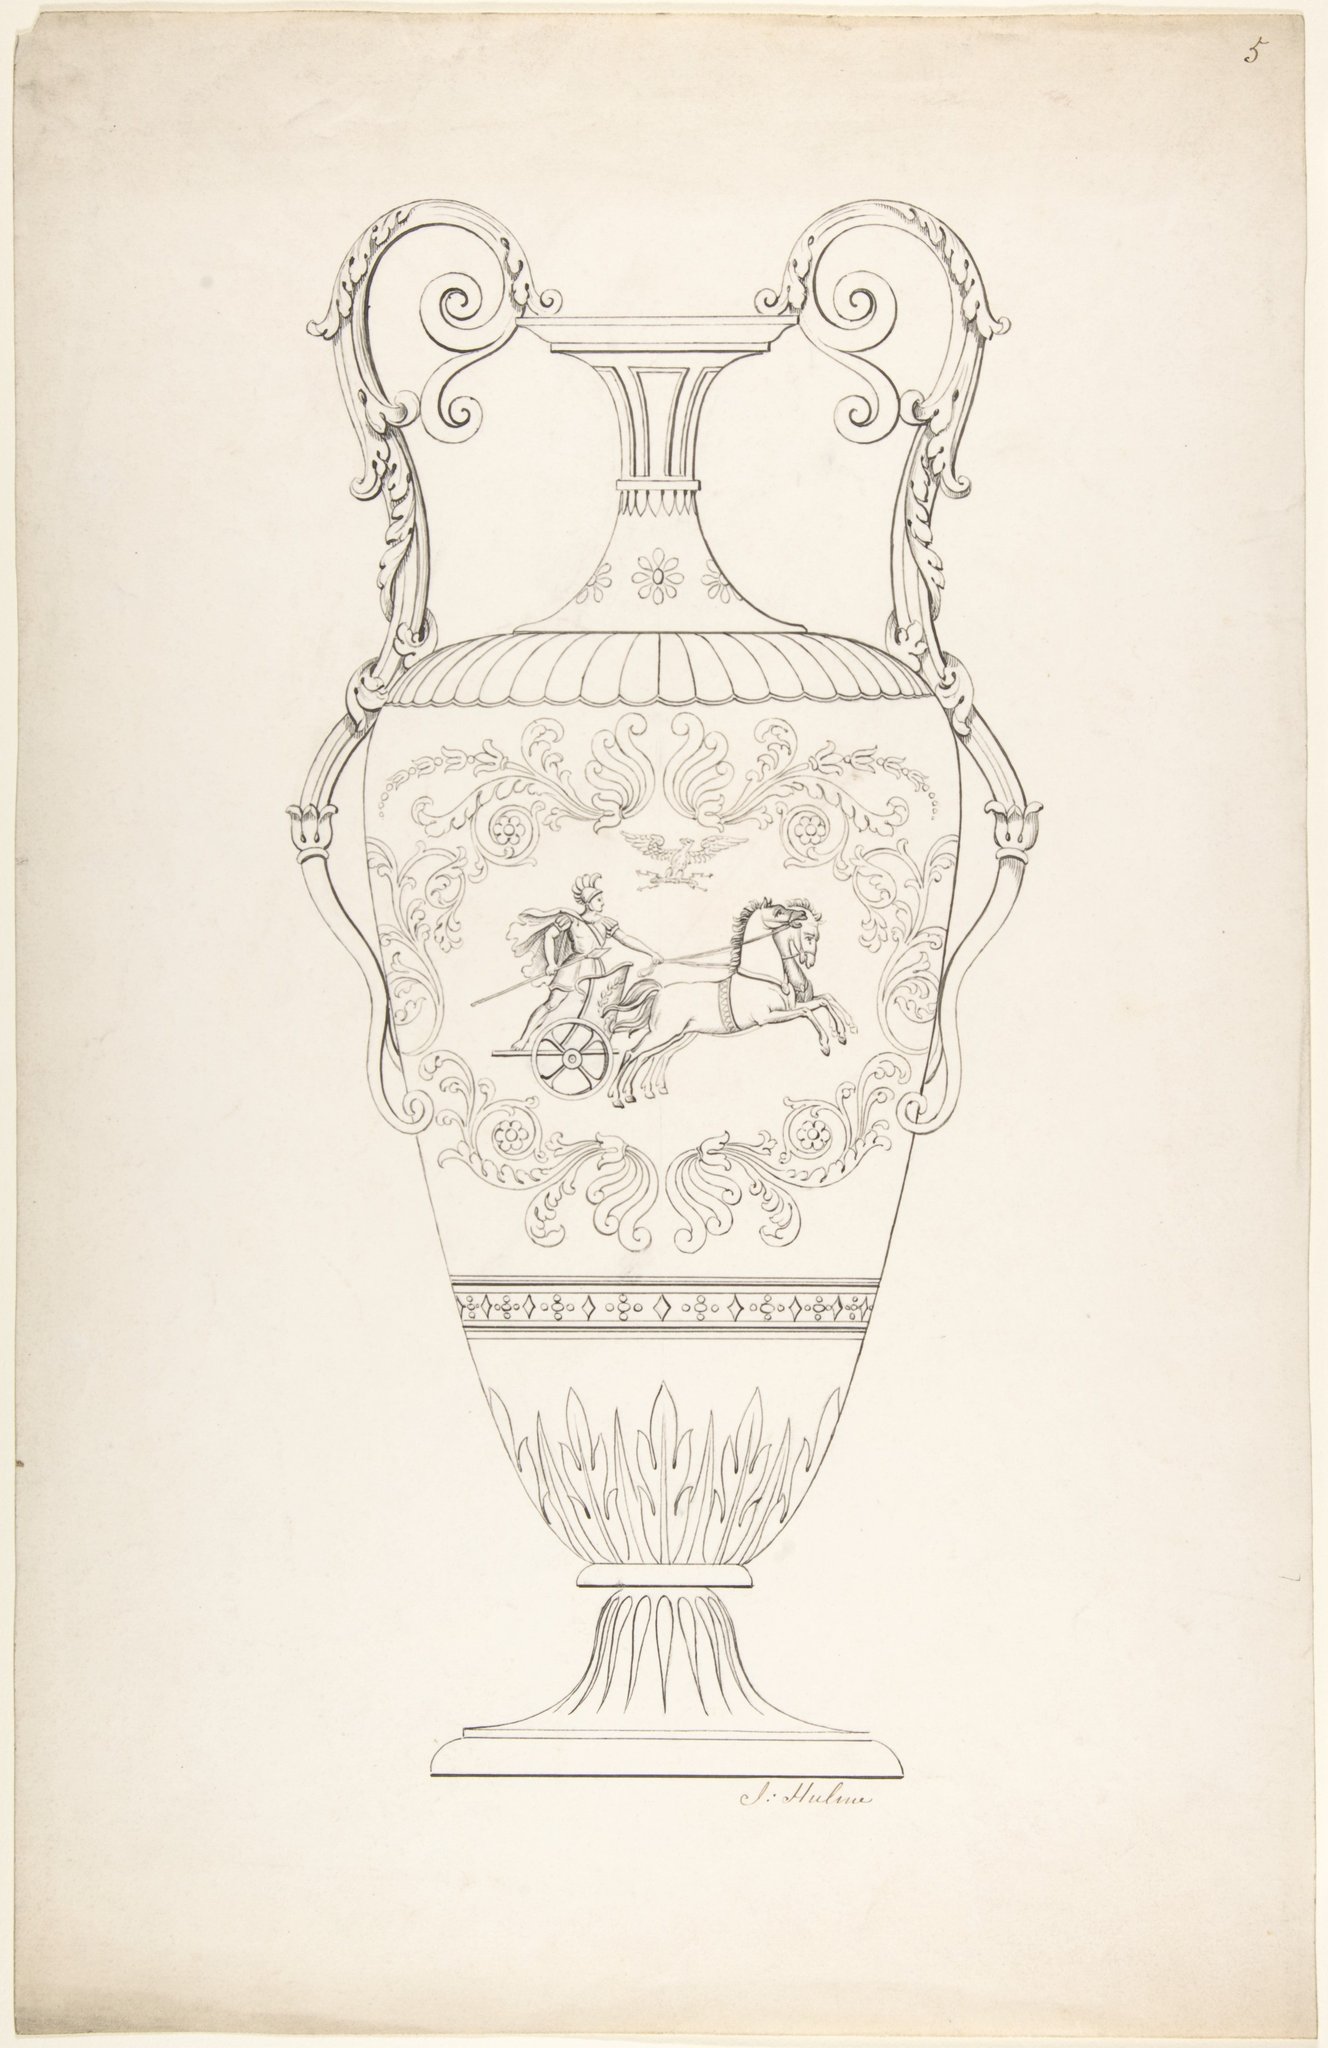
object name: drawing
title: Design for a Vase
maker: j. hulme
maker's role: artist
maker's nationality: british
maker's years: 1800-1880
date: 1828-1840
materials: ink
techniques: pen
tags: men,horses,chariots,vases